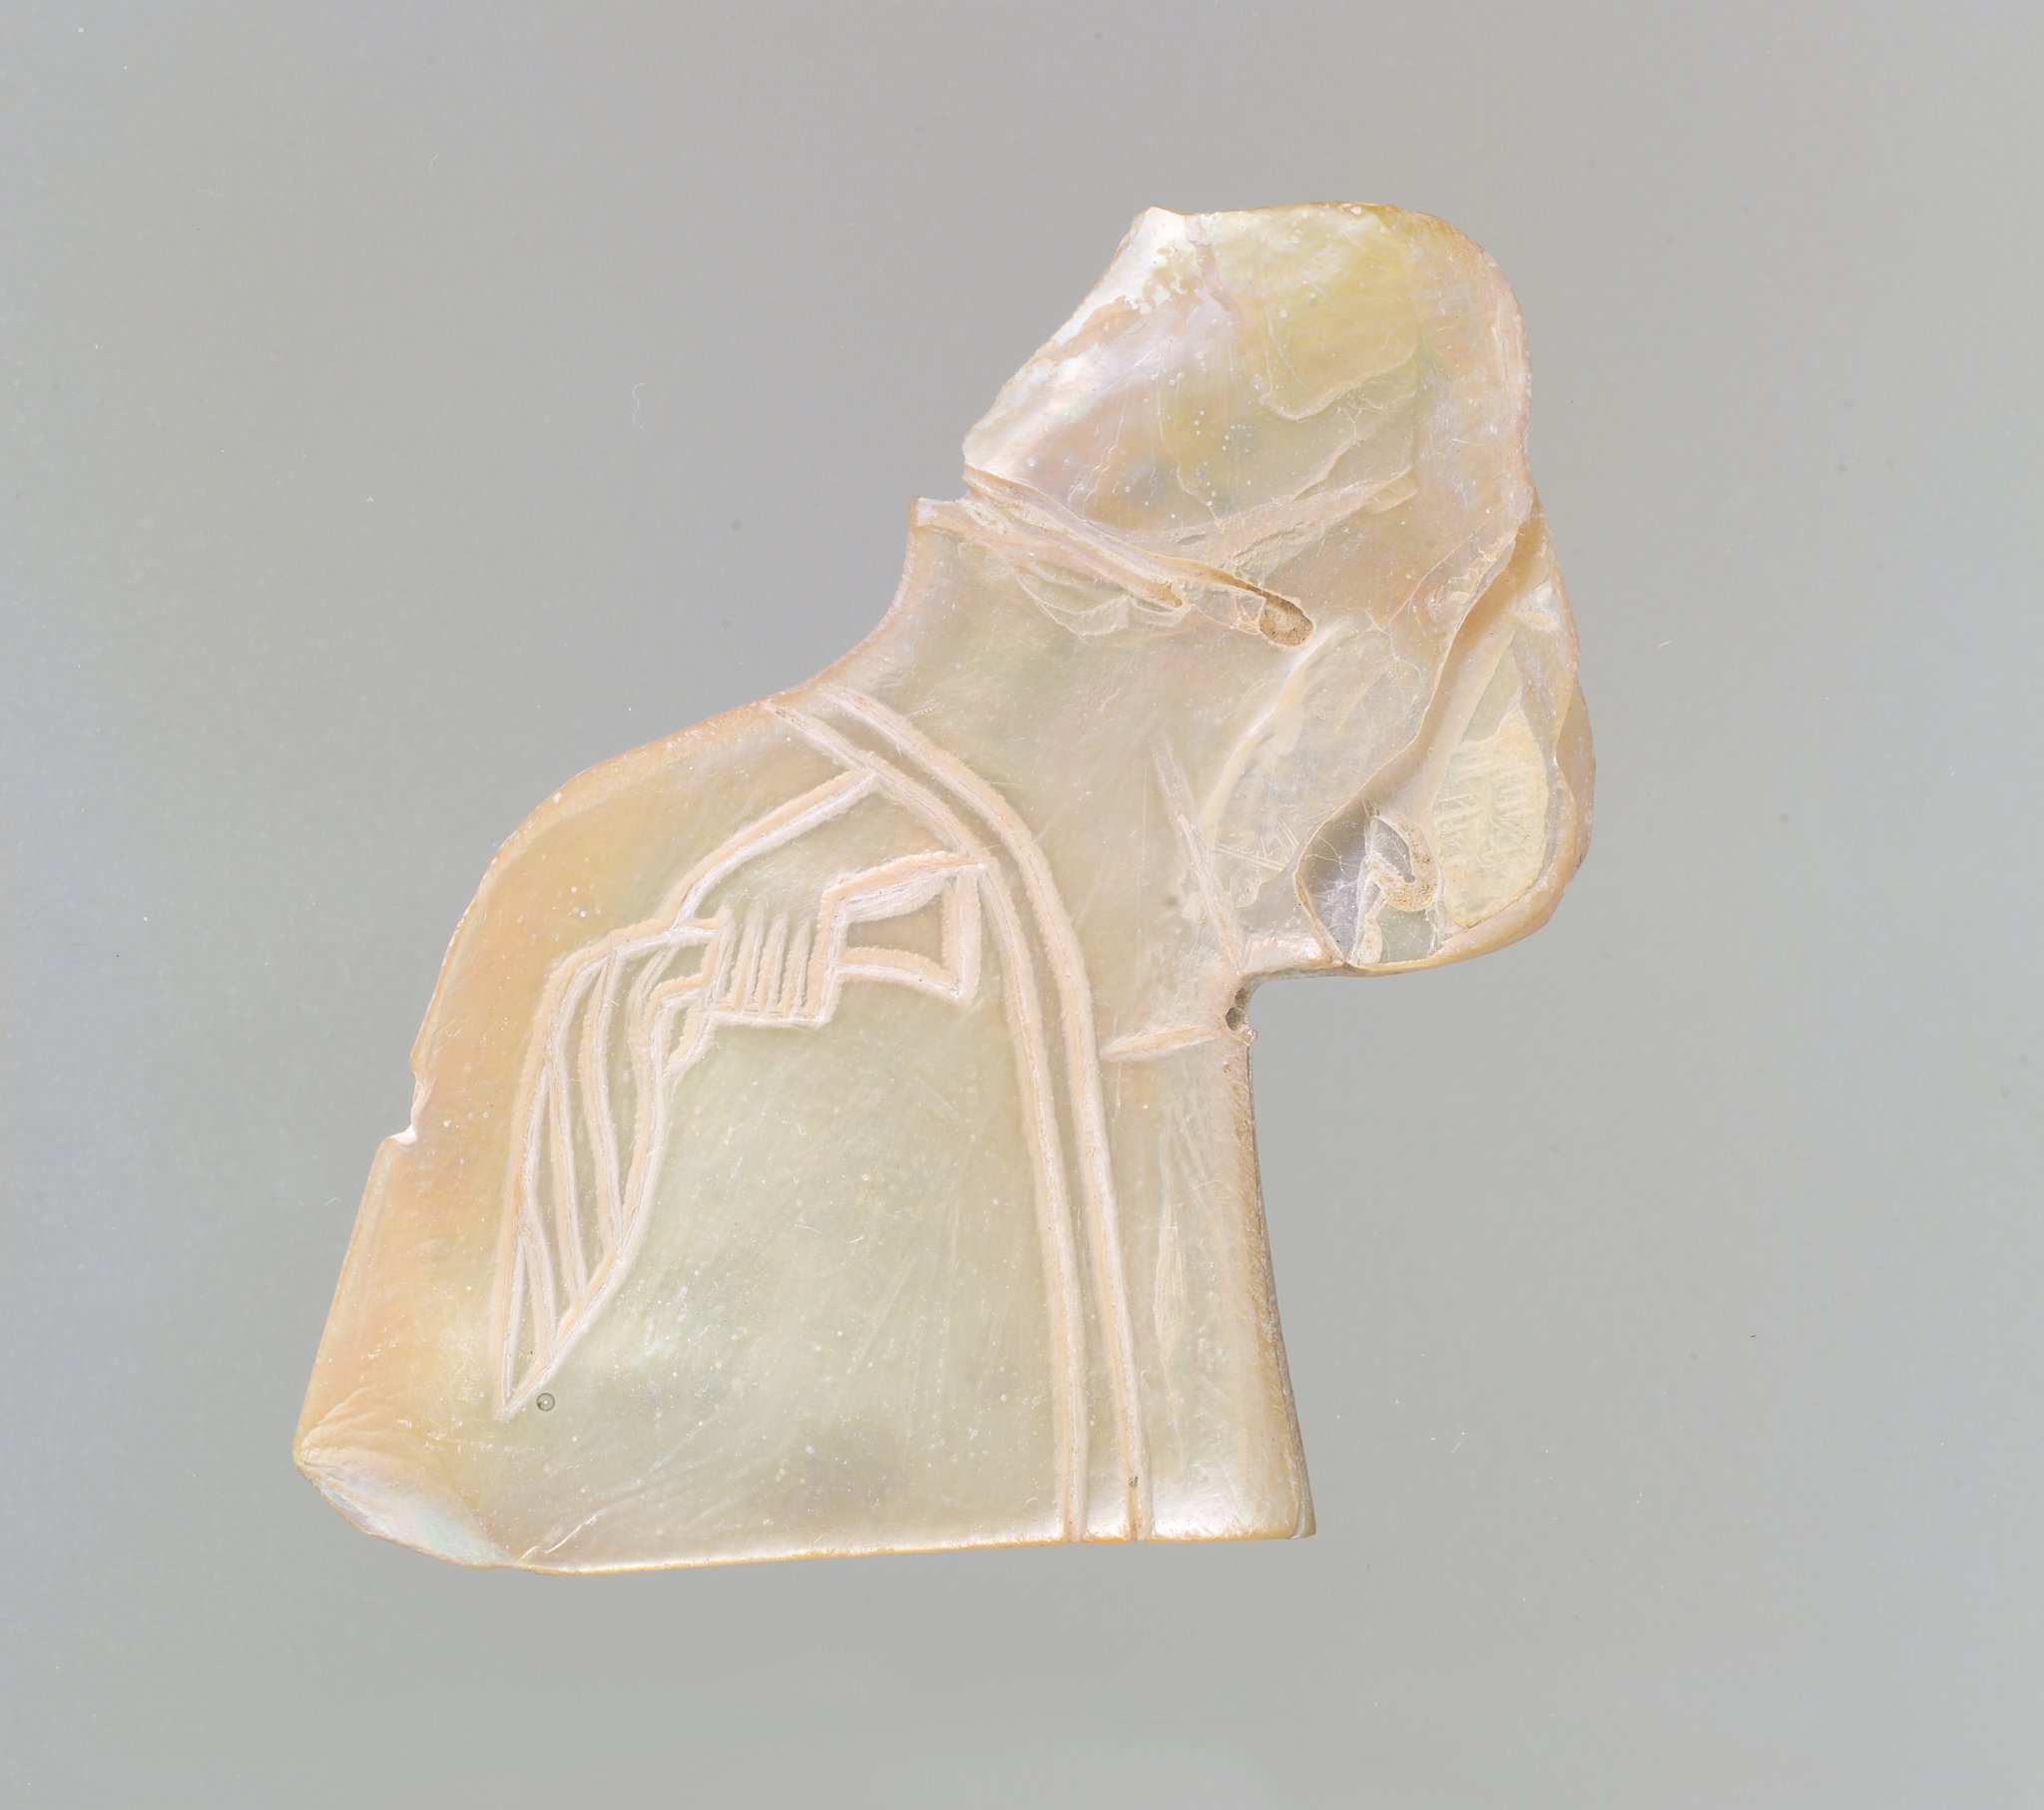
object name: inlay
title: Inlay: banquet scene with a seated figure holding a palm frond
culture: sumerian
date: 2600-2500 BCE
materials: shell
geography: mesopotamia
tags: palms